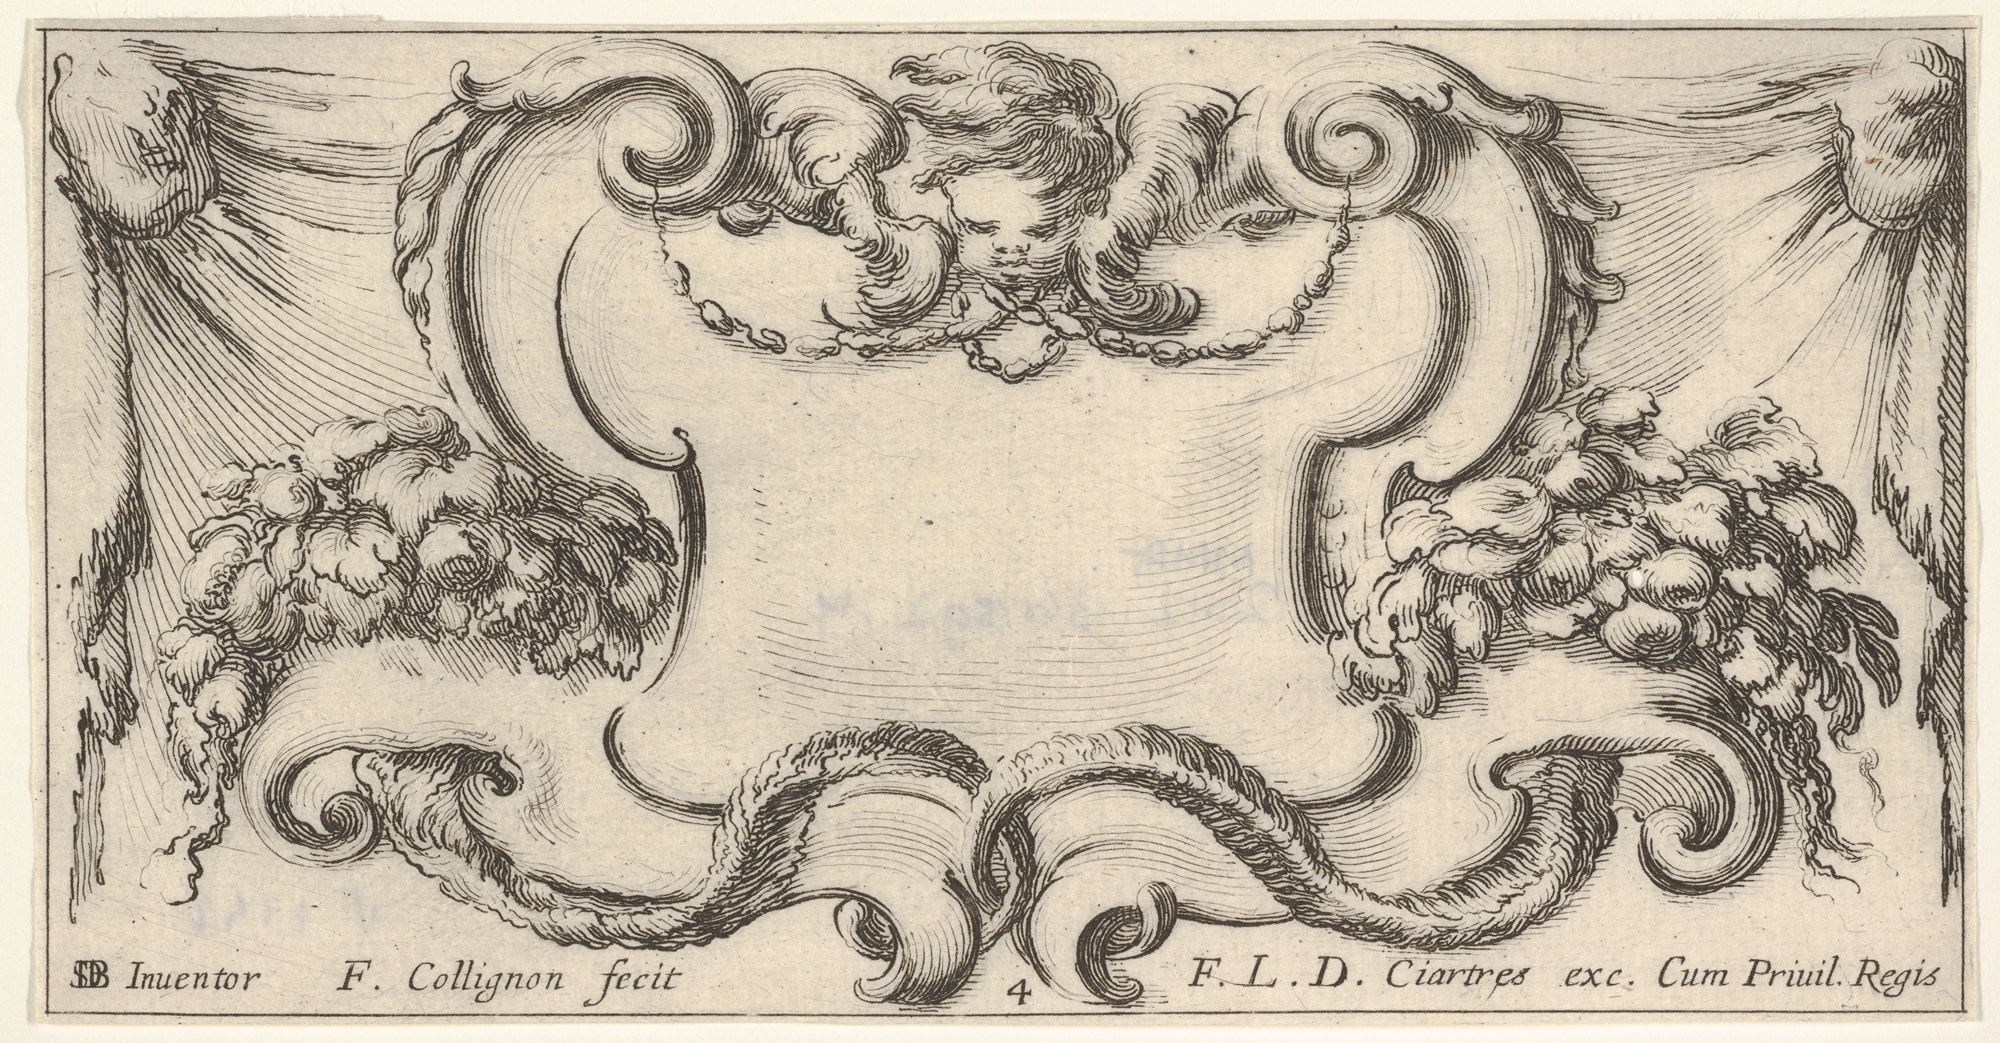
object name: print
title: Plate 4: a cartouche with the head of a cherub at top center, leaves and flowers to either side, from "Twelve cartouches" (Recueil de douze cartouches)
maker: françois collignon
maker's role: artist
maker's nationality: french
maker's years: 1605-1687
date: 1640-1645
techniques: etching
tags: cartouches,flowers